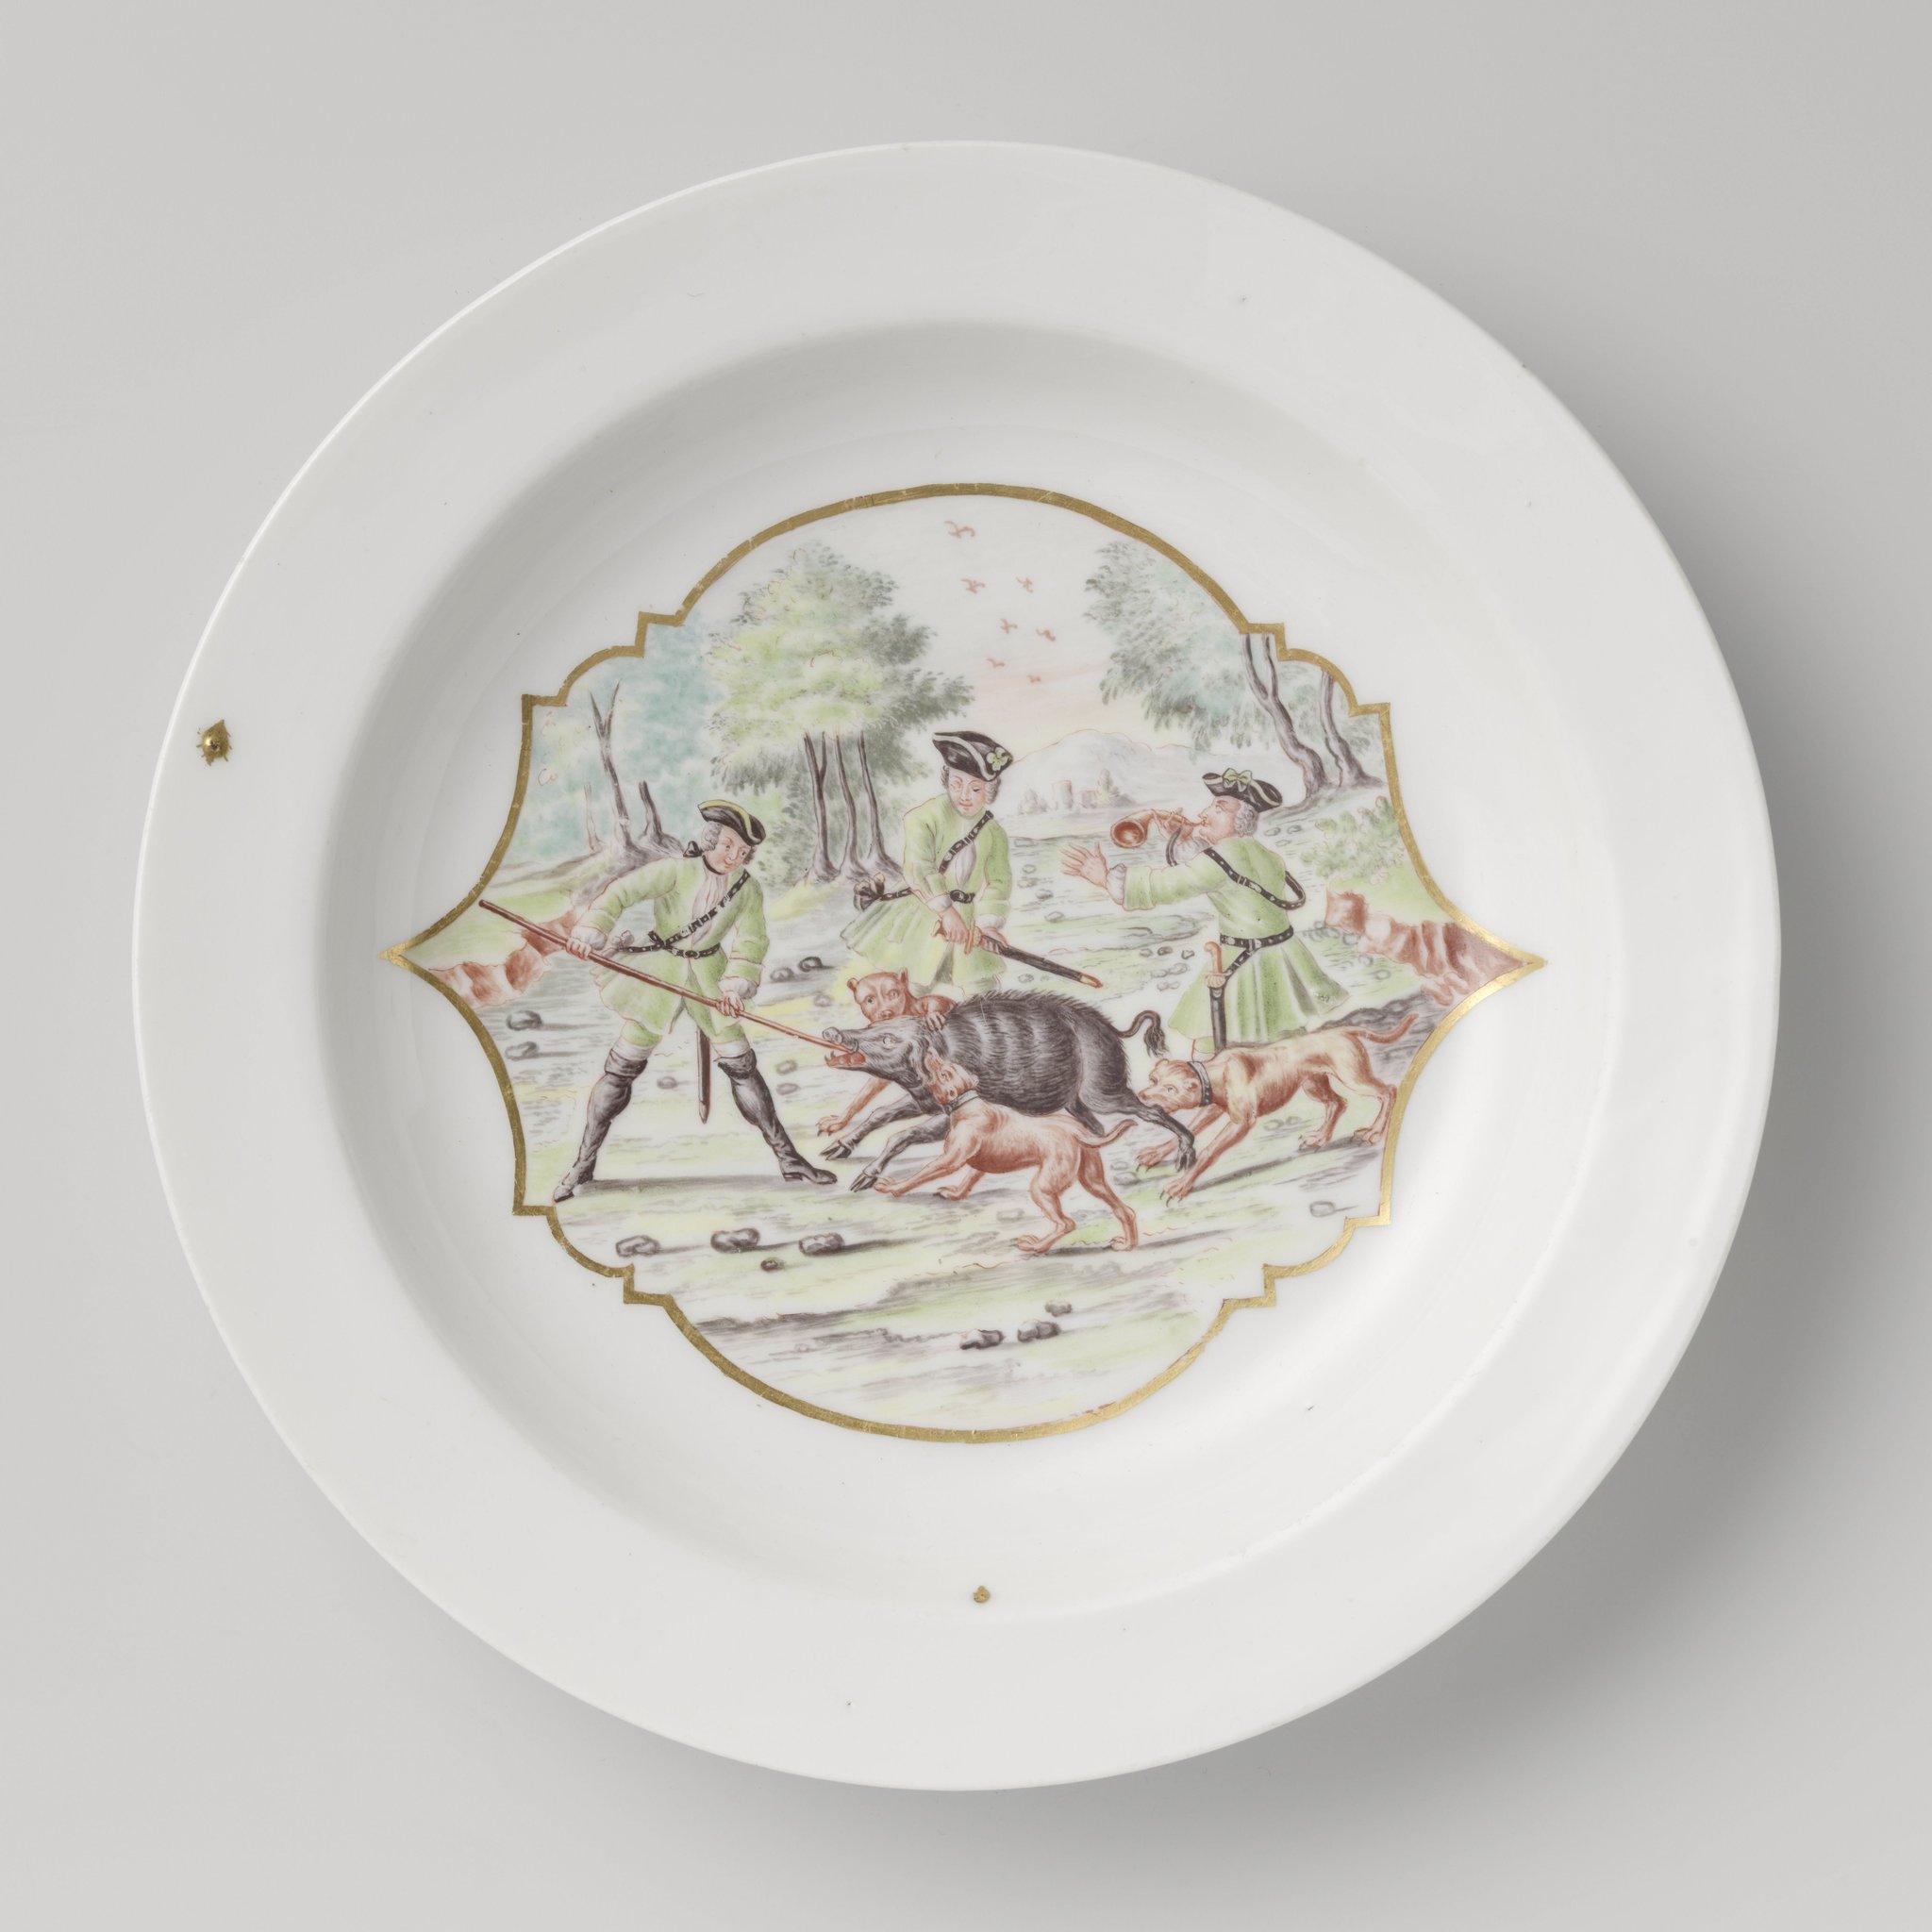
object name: plate dish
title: Bord, veelkleurig beschilderd met een zwijnenjacht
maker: franz ferdinand mayer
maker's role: porseleinschilder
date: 1750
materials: porcelain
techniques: painted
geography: prísecná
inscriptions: factory mark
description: Two plates with hunting scenes. Porcelain, Meissen, c. 1750, decorated by the 'Hausmaler' Franz Ferdinand Mayer von Pressnitz.